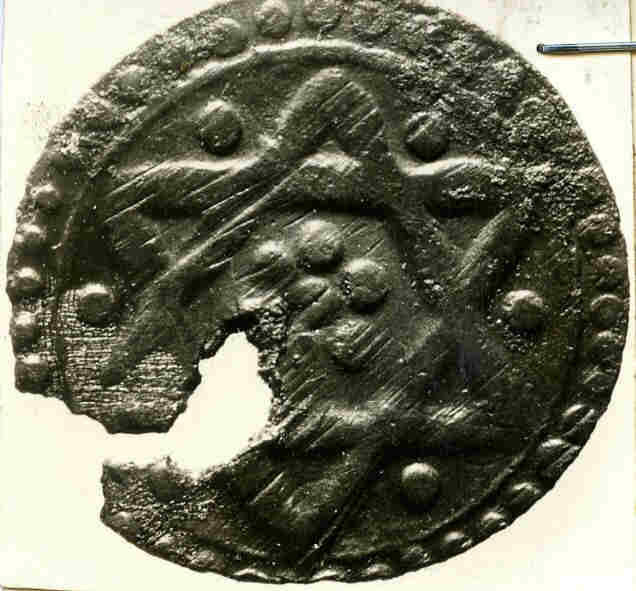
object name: coin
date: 1067-1233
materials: copper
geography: iran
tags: stars